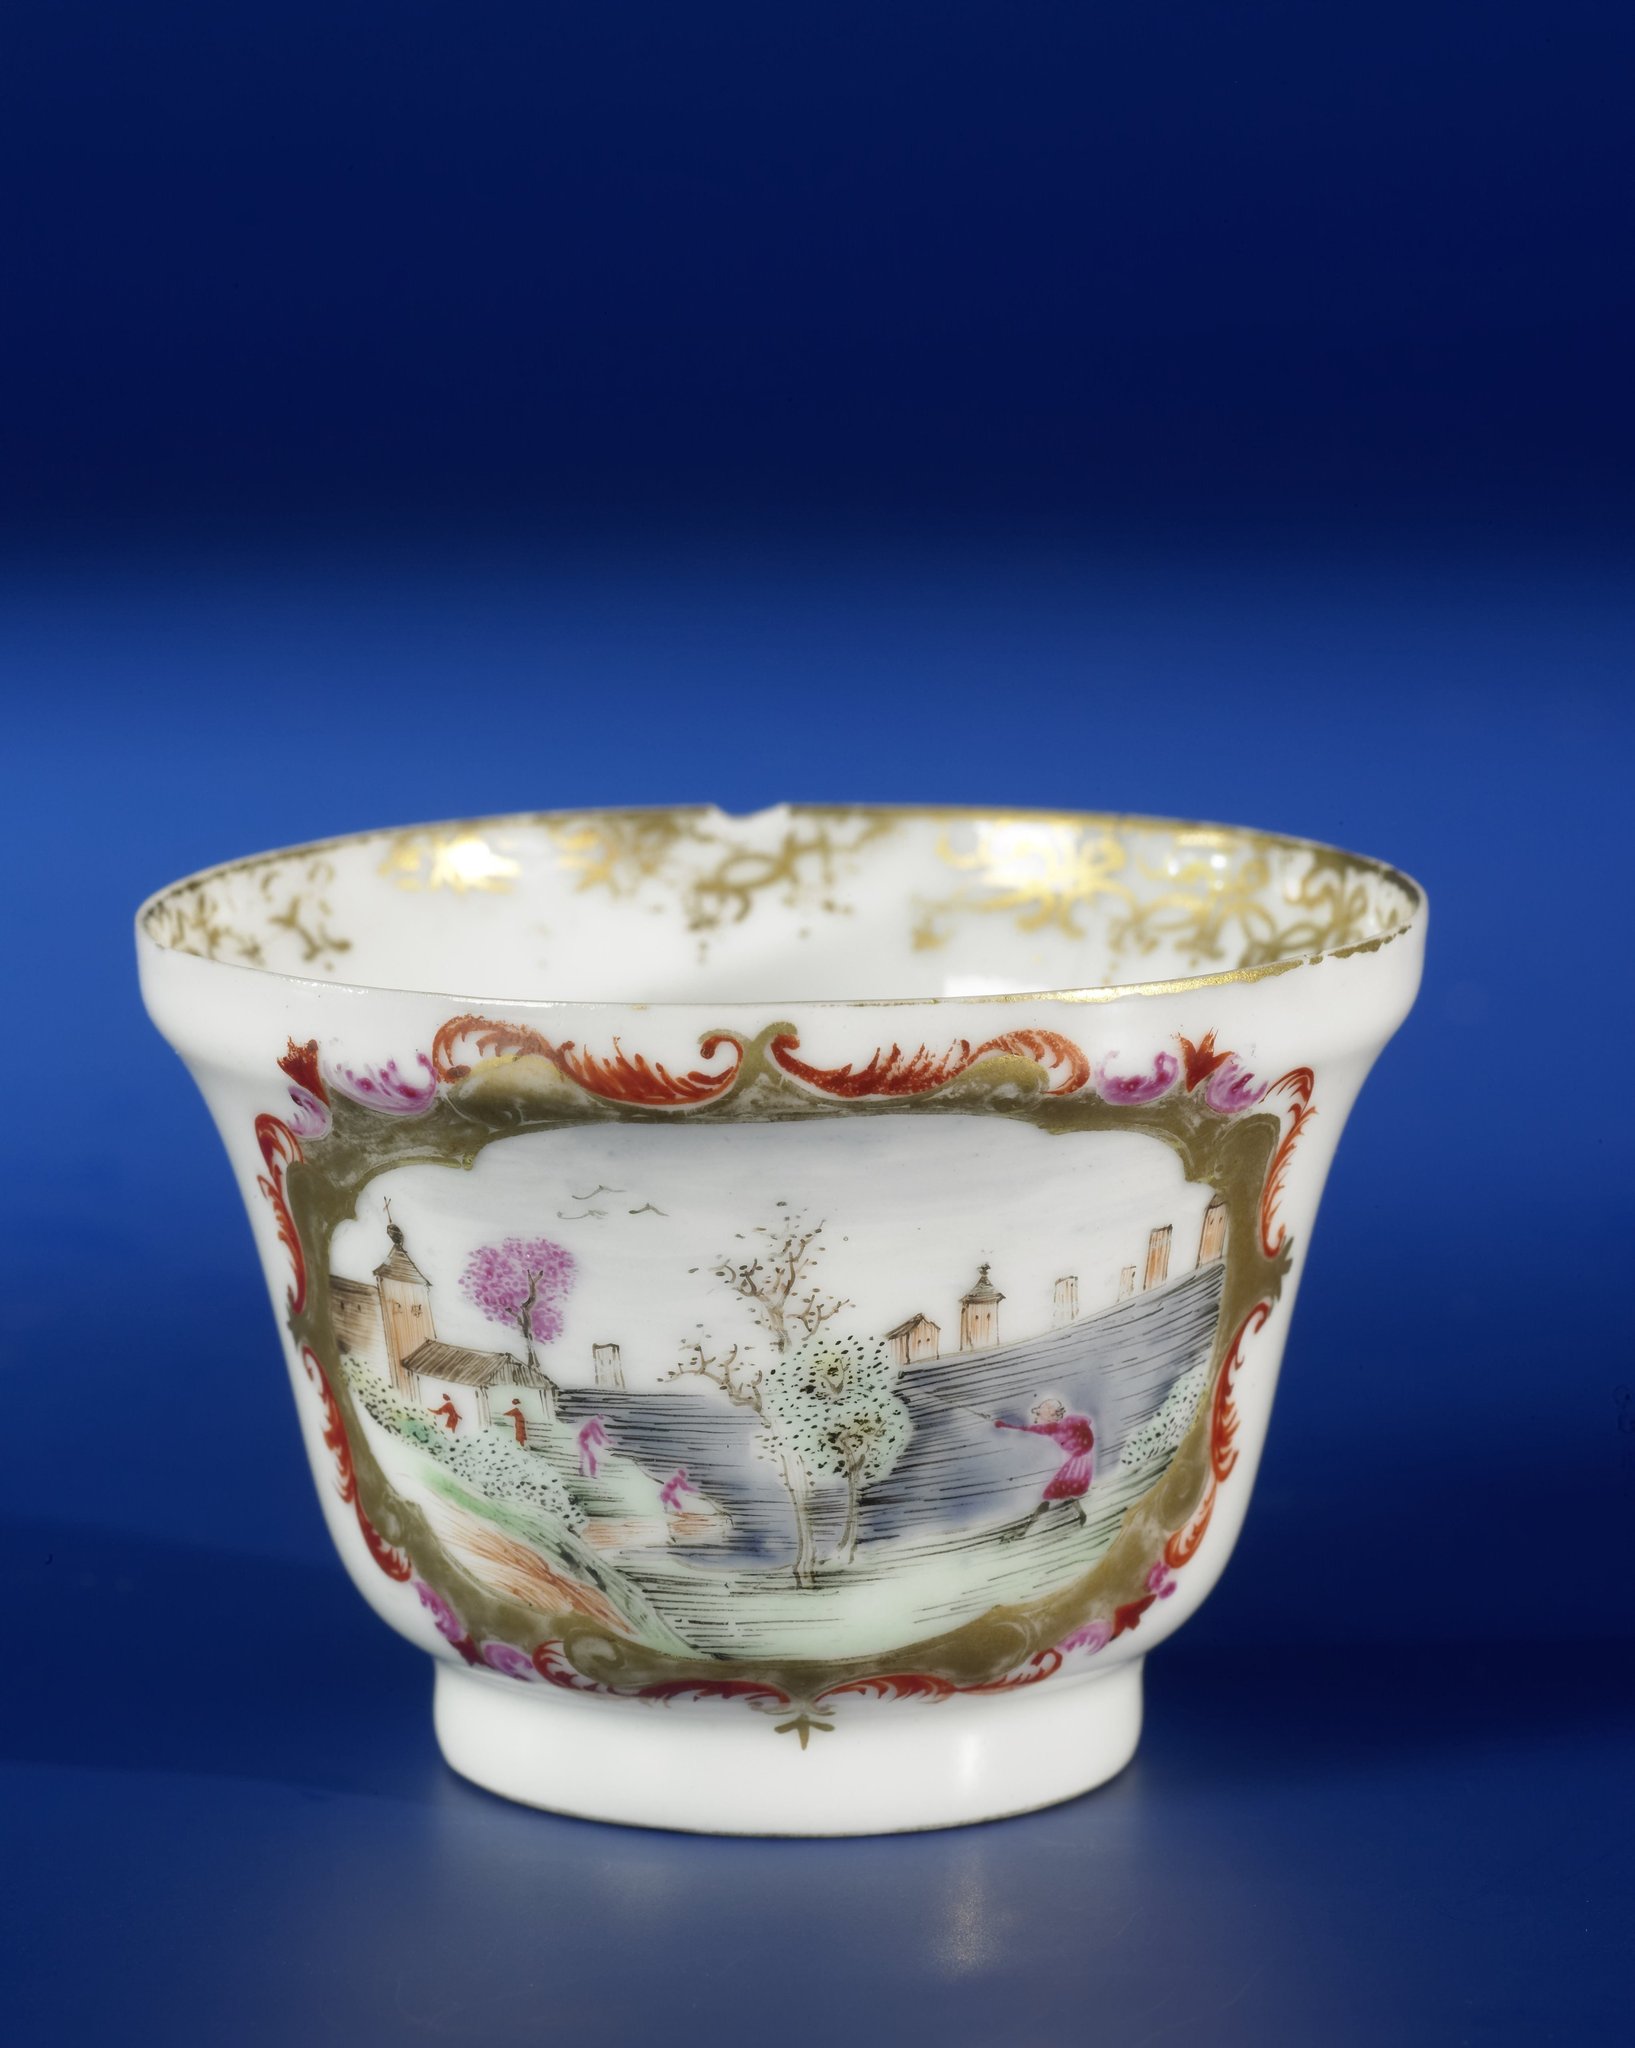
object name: cup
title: Bell-shaped cup with European landscapes in panels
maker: Anonymous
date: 1740-1760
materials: glaze, gold, paint, porcelain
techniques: firing, gilding, turning, vitrification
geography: china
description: Theekom op een hoge voetring, gedecoreerd in emailkleuren. Binnen een cartouche een havengezicht, met twee mannen en een hond op de kade, op de achtergrond een fort. Aan de binnenkant is de rand versierd met een decoratief patroon.